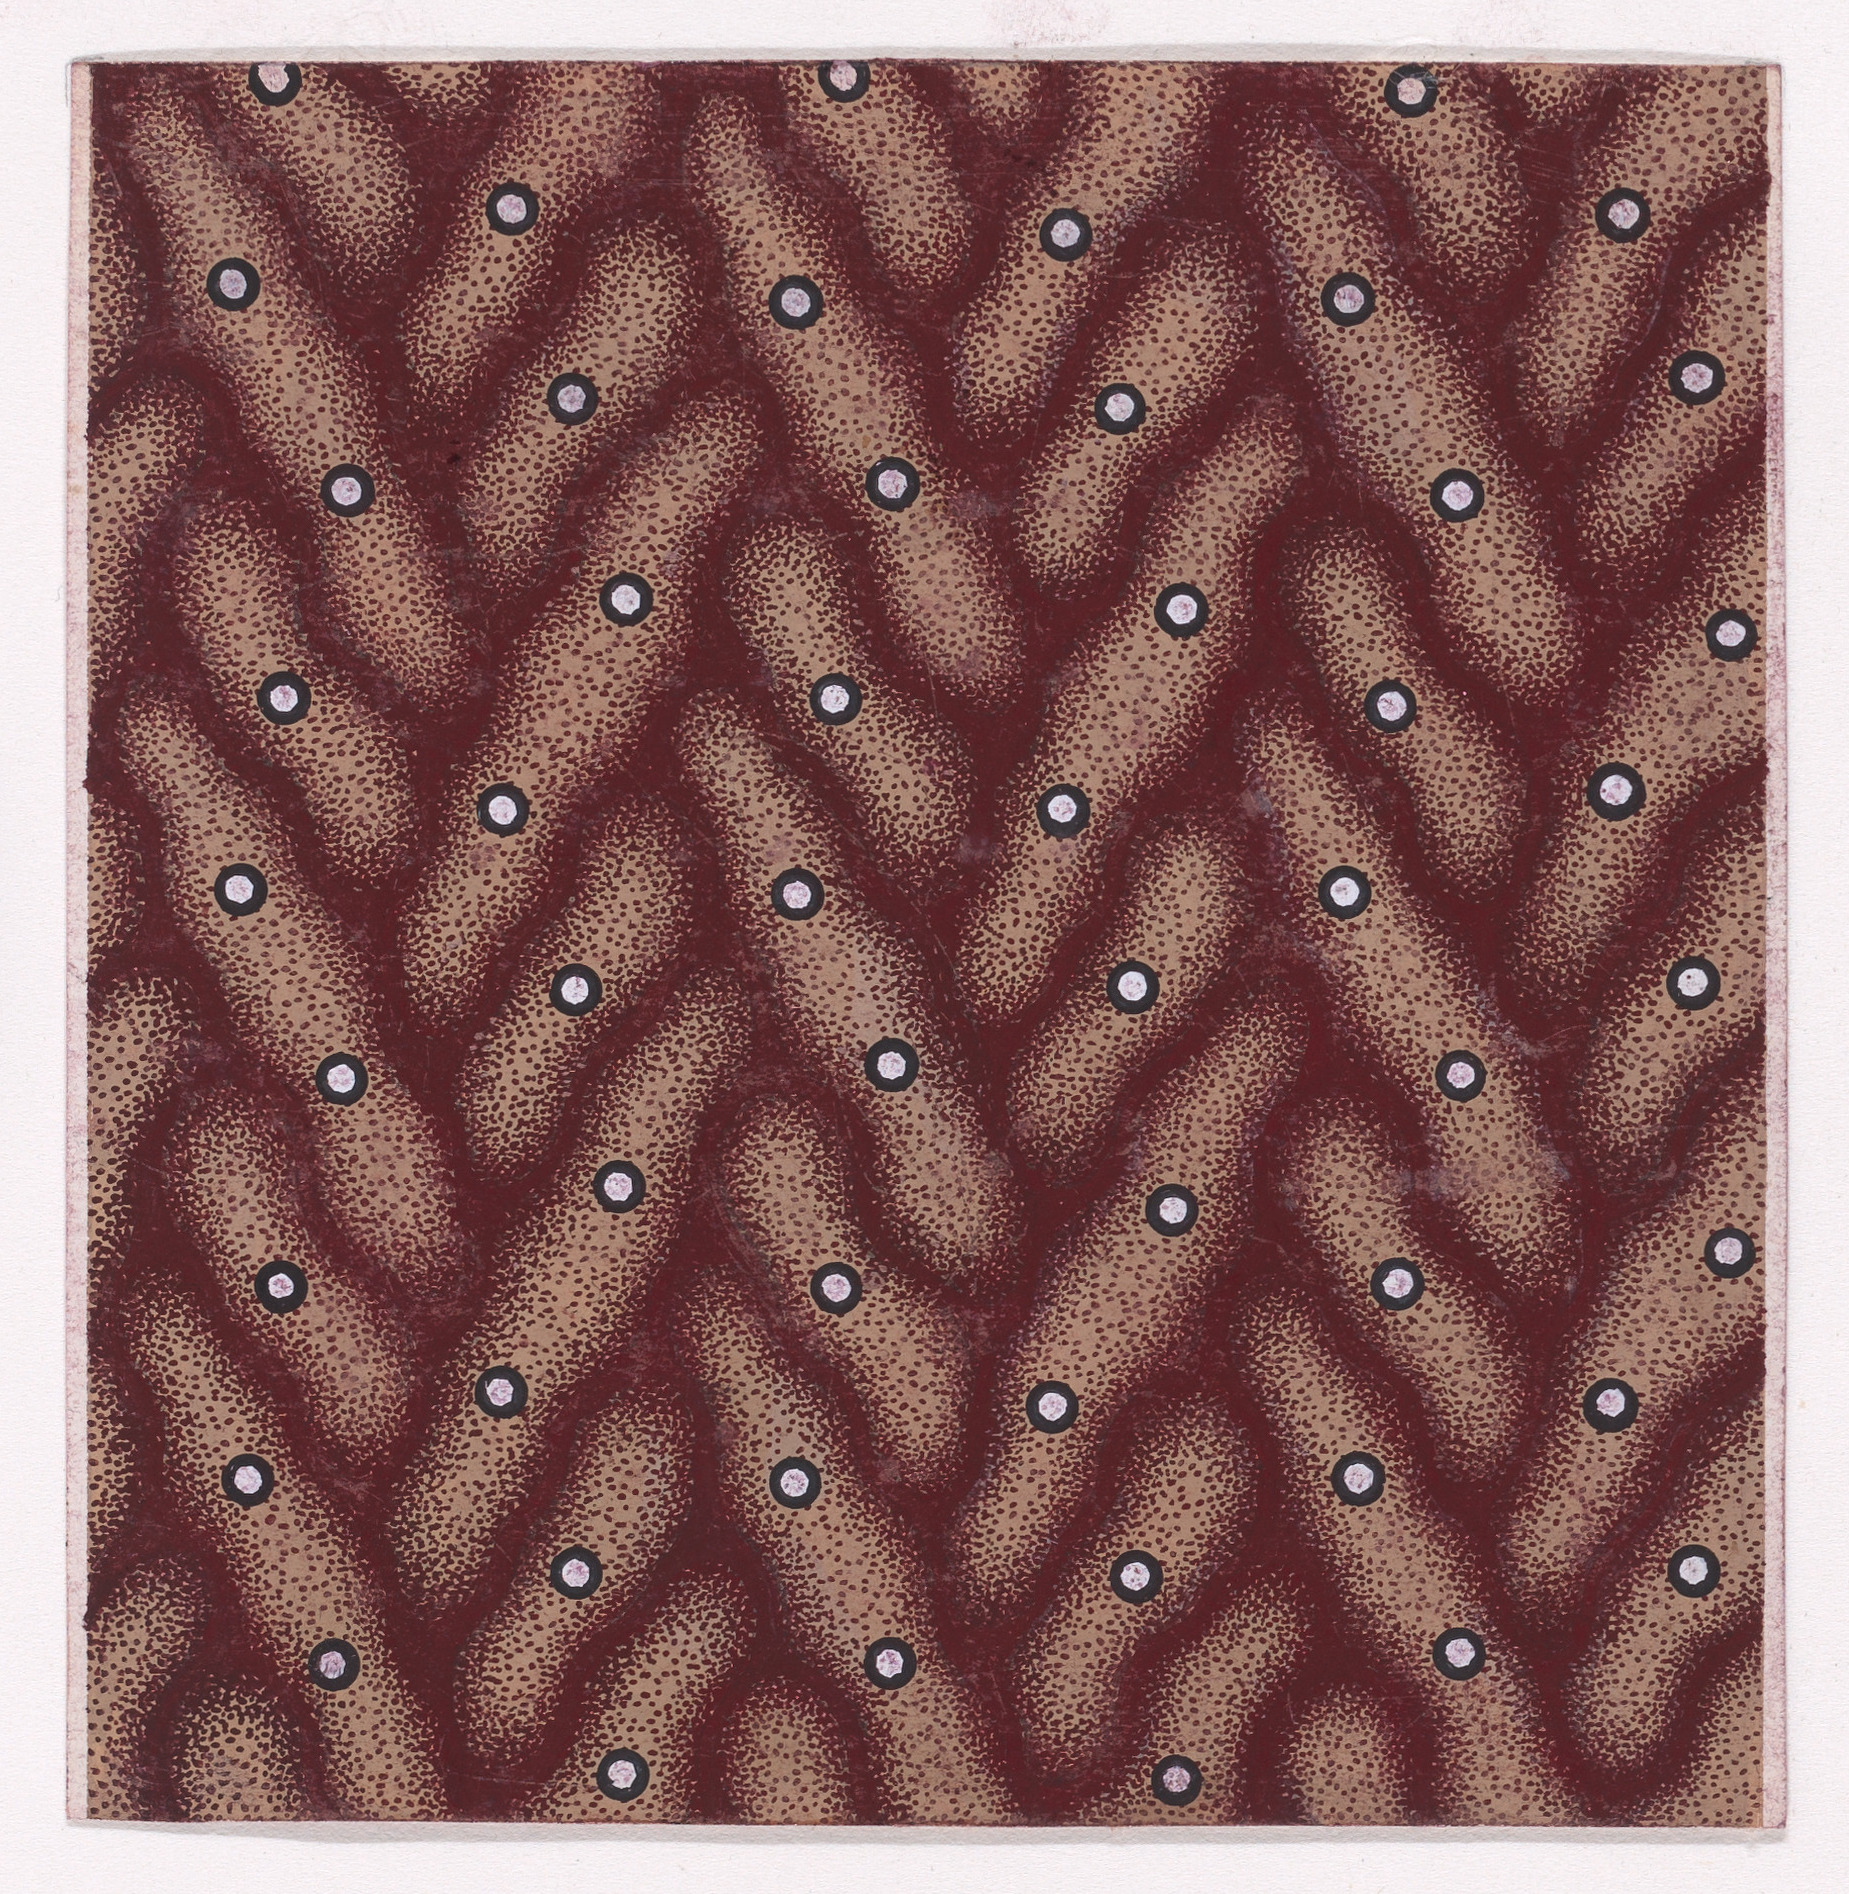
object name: drawing ornament architecture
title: Textile Design with Scattered Pearls over an Abstract Background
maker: anonymous, alsatian, 19th century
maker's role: artist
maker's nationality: alsatian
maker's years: 1800-1900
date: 1840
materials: gouache